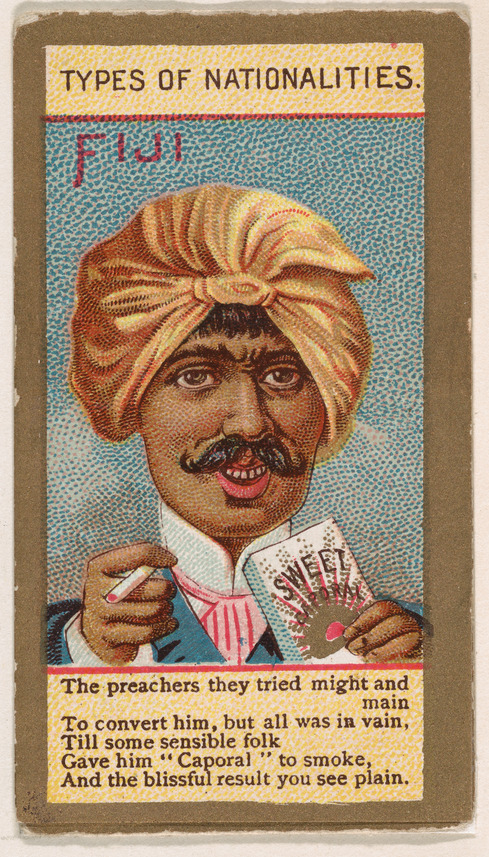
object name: print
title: Fiji, from Types of Nationalities (N240) issued by Kinney Bros.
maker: kinney brothers tobacco company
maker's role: publisher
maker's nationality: american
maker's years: 1869-2011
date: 1890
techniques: color lithograph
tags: men,smoking